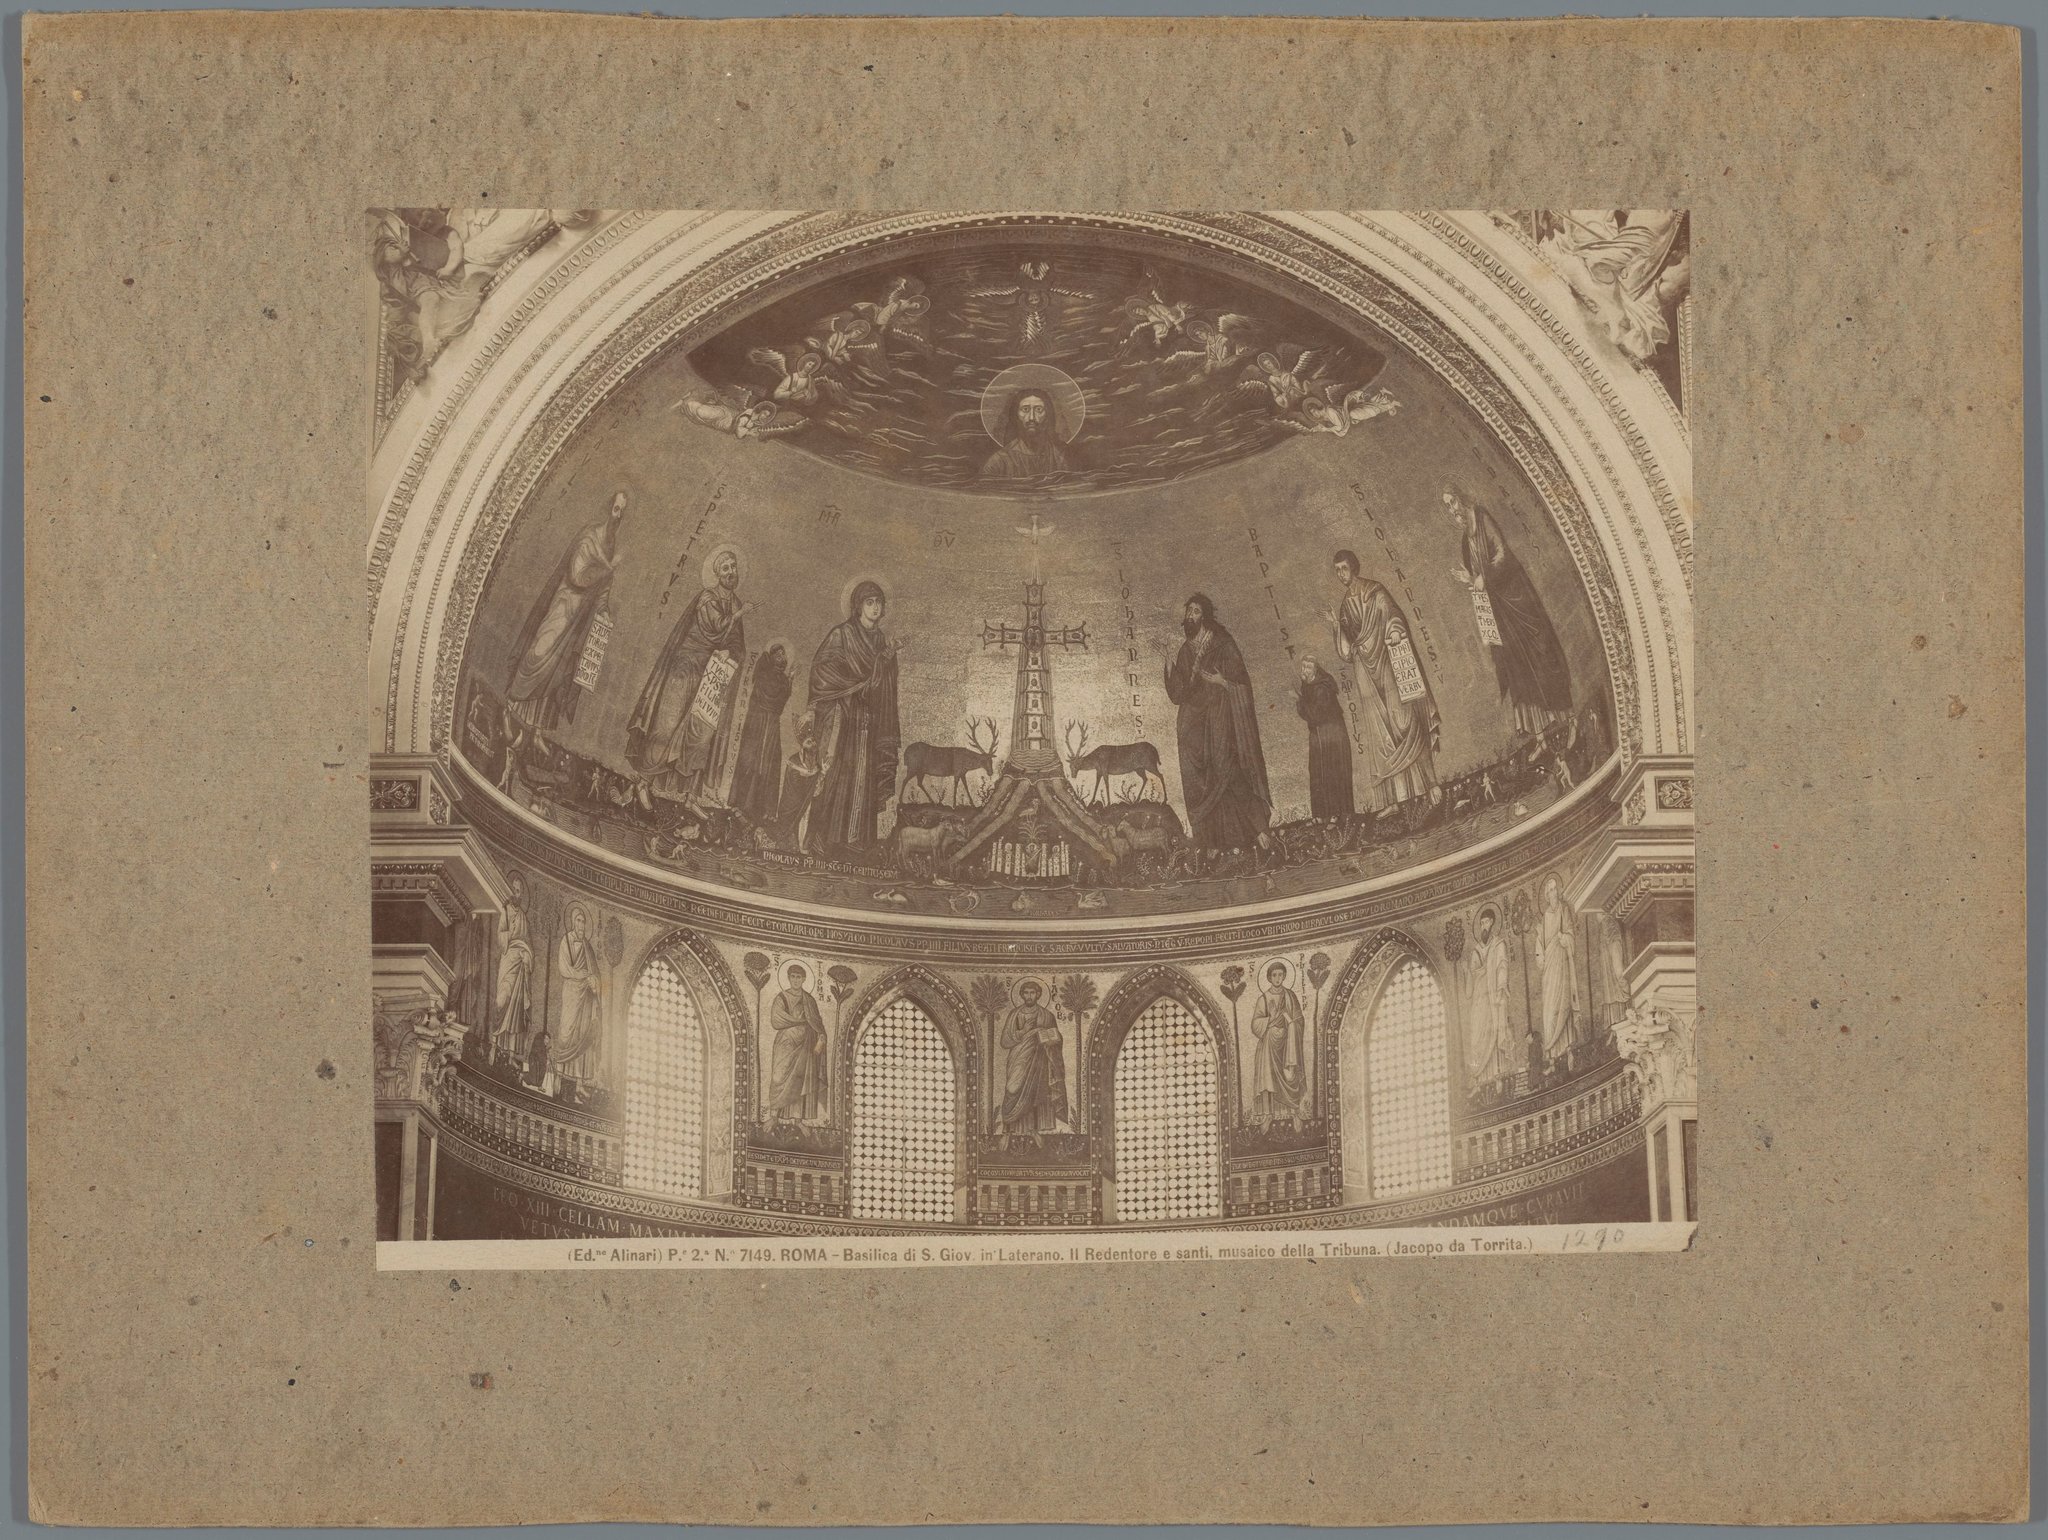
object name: photograph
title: Mozaïek in de Sint-Jan van Lateranen te Rome, voorstellende Christus en heiligen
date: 1875-1900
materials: cardboard, photographic support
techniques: albumen print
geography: sint-jan van lateranen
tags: art (+ mosaic making), saints, christ, interior of church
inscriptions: collector's mark: Lugt 3937, number: ‘P.e 2.a N.o 7149.’